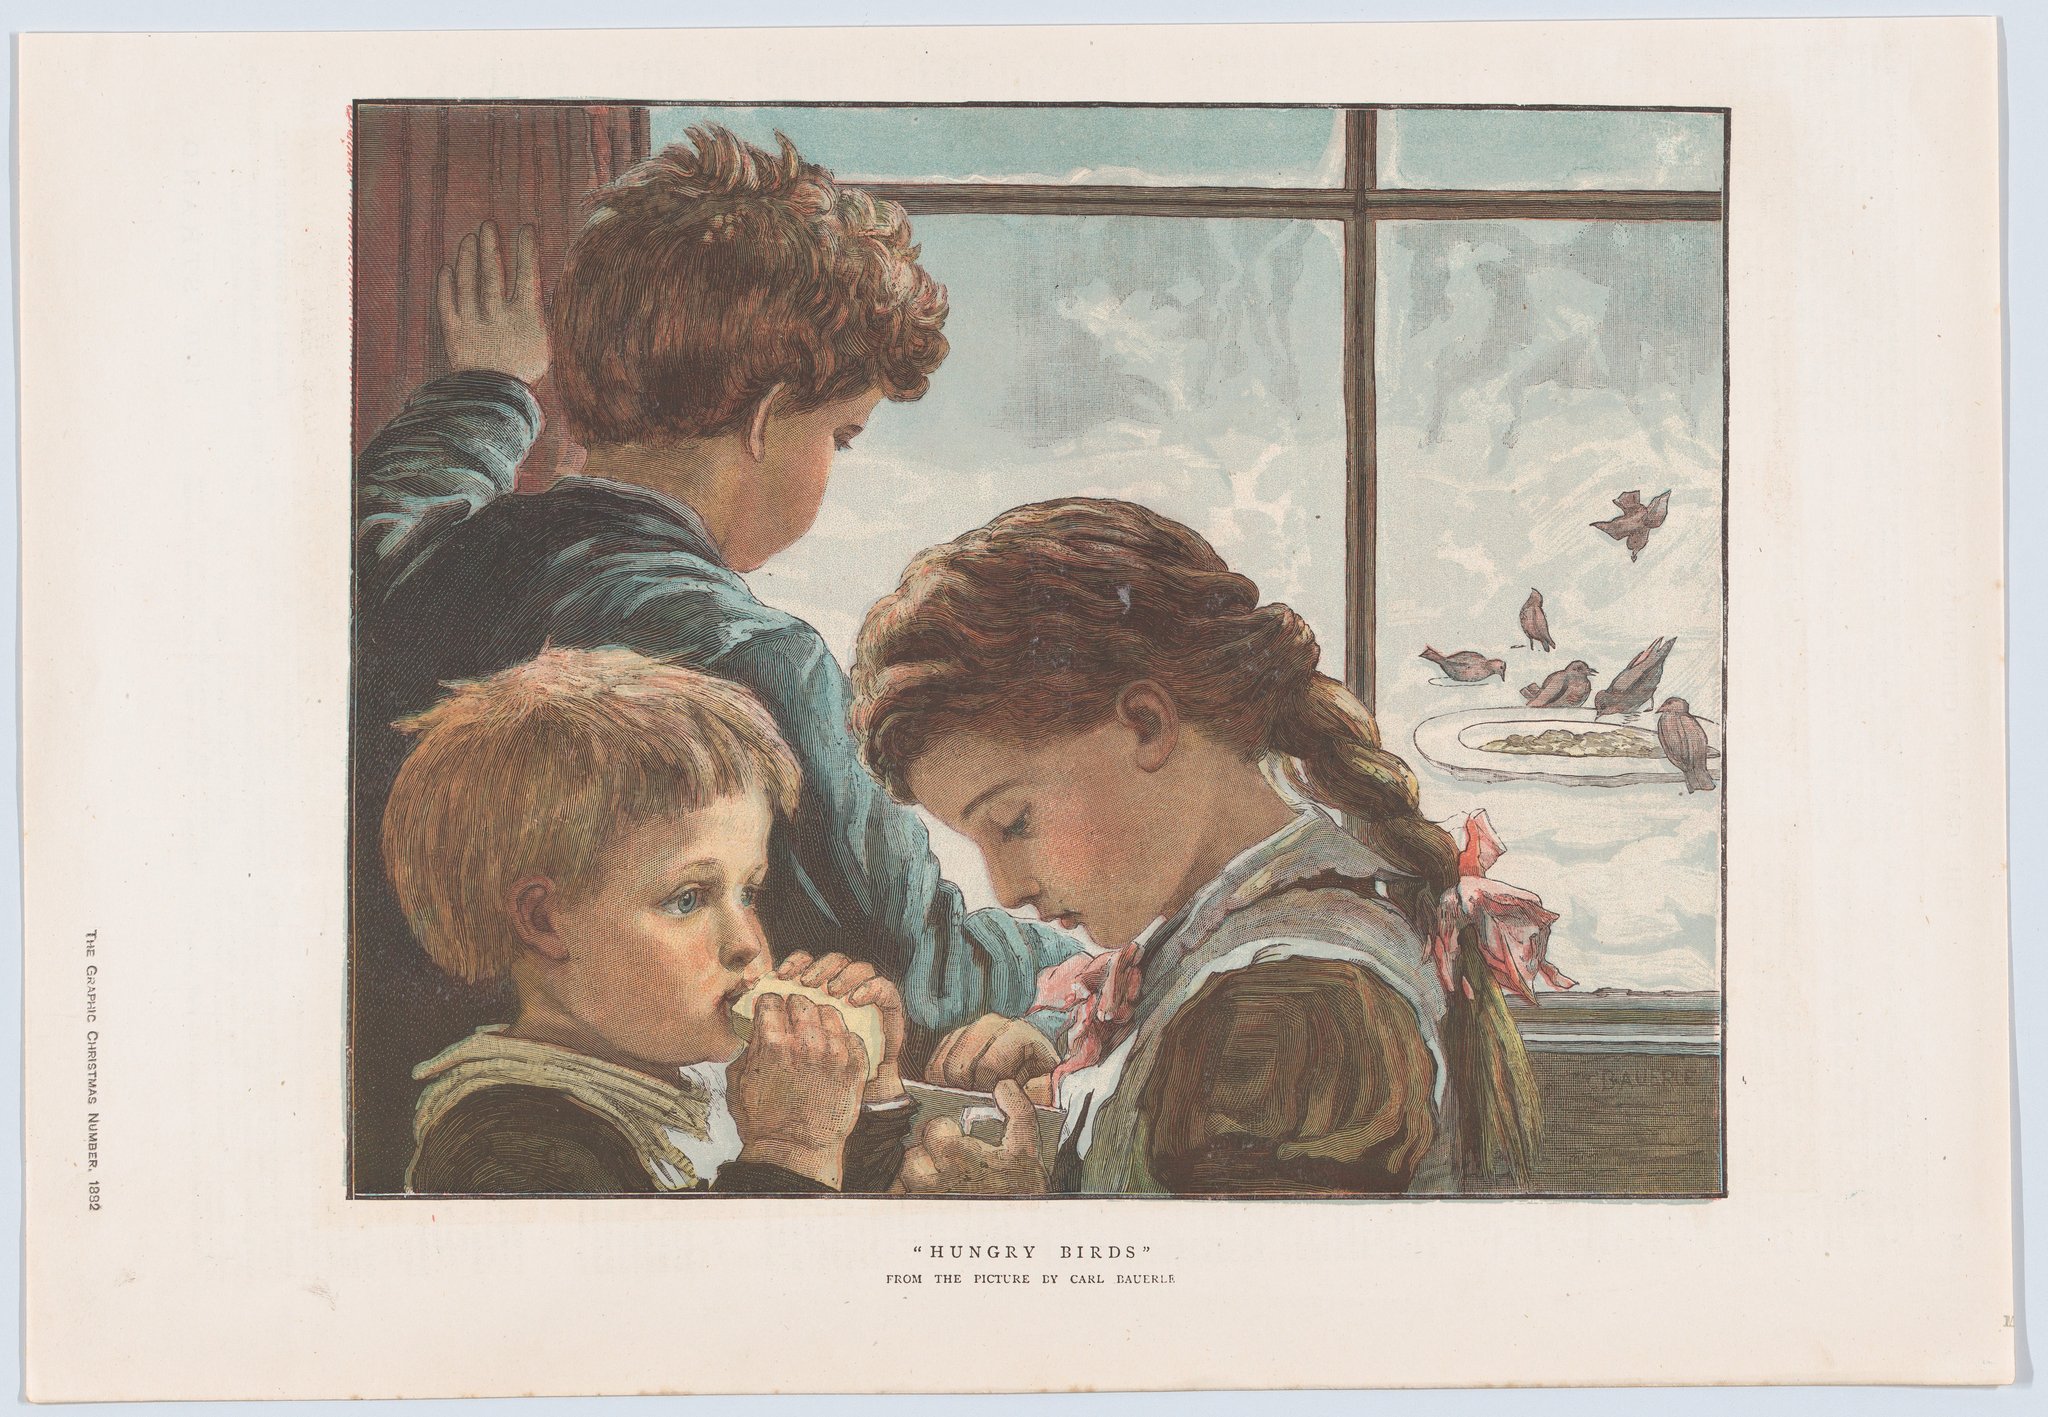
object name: print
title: Hungry Birds, from "The Graphic" Christmas Number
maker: karl wilhelm friedrich bauerle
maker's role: artist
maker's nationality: german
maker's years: 1831-1912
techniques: engraving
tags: birds,boys,girls